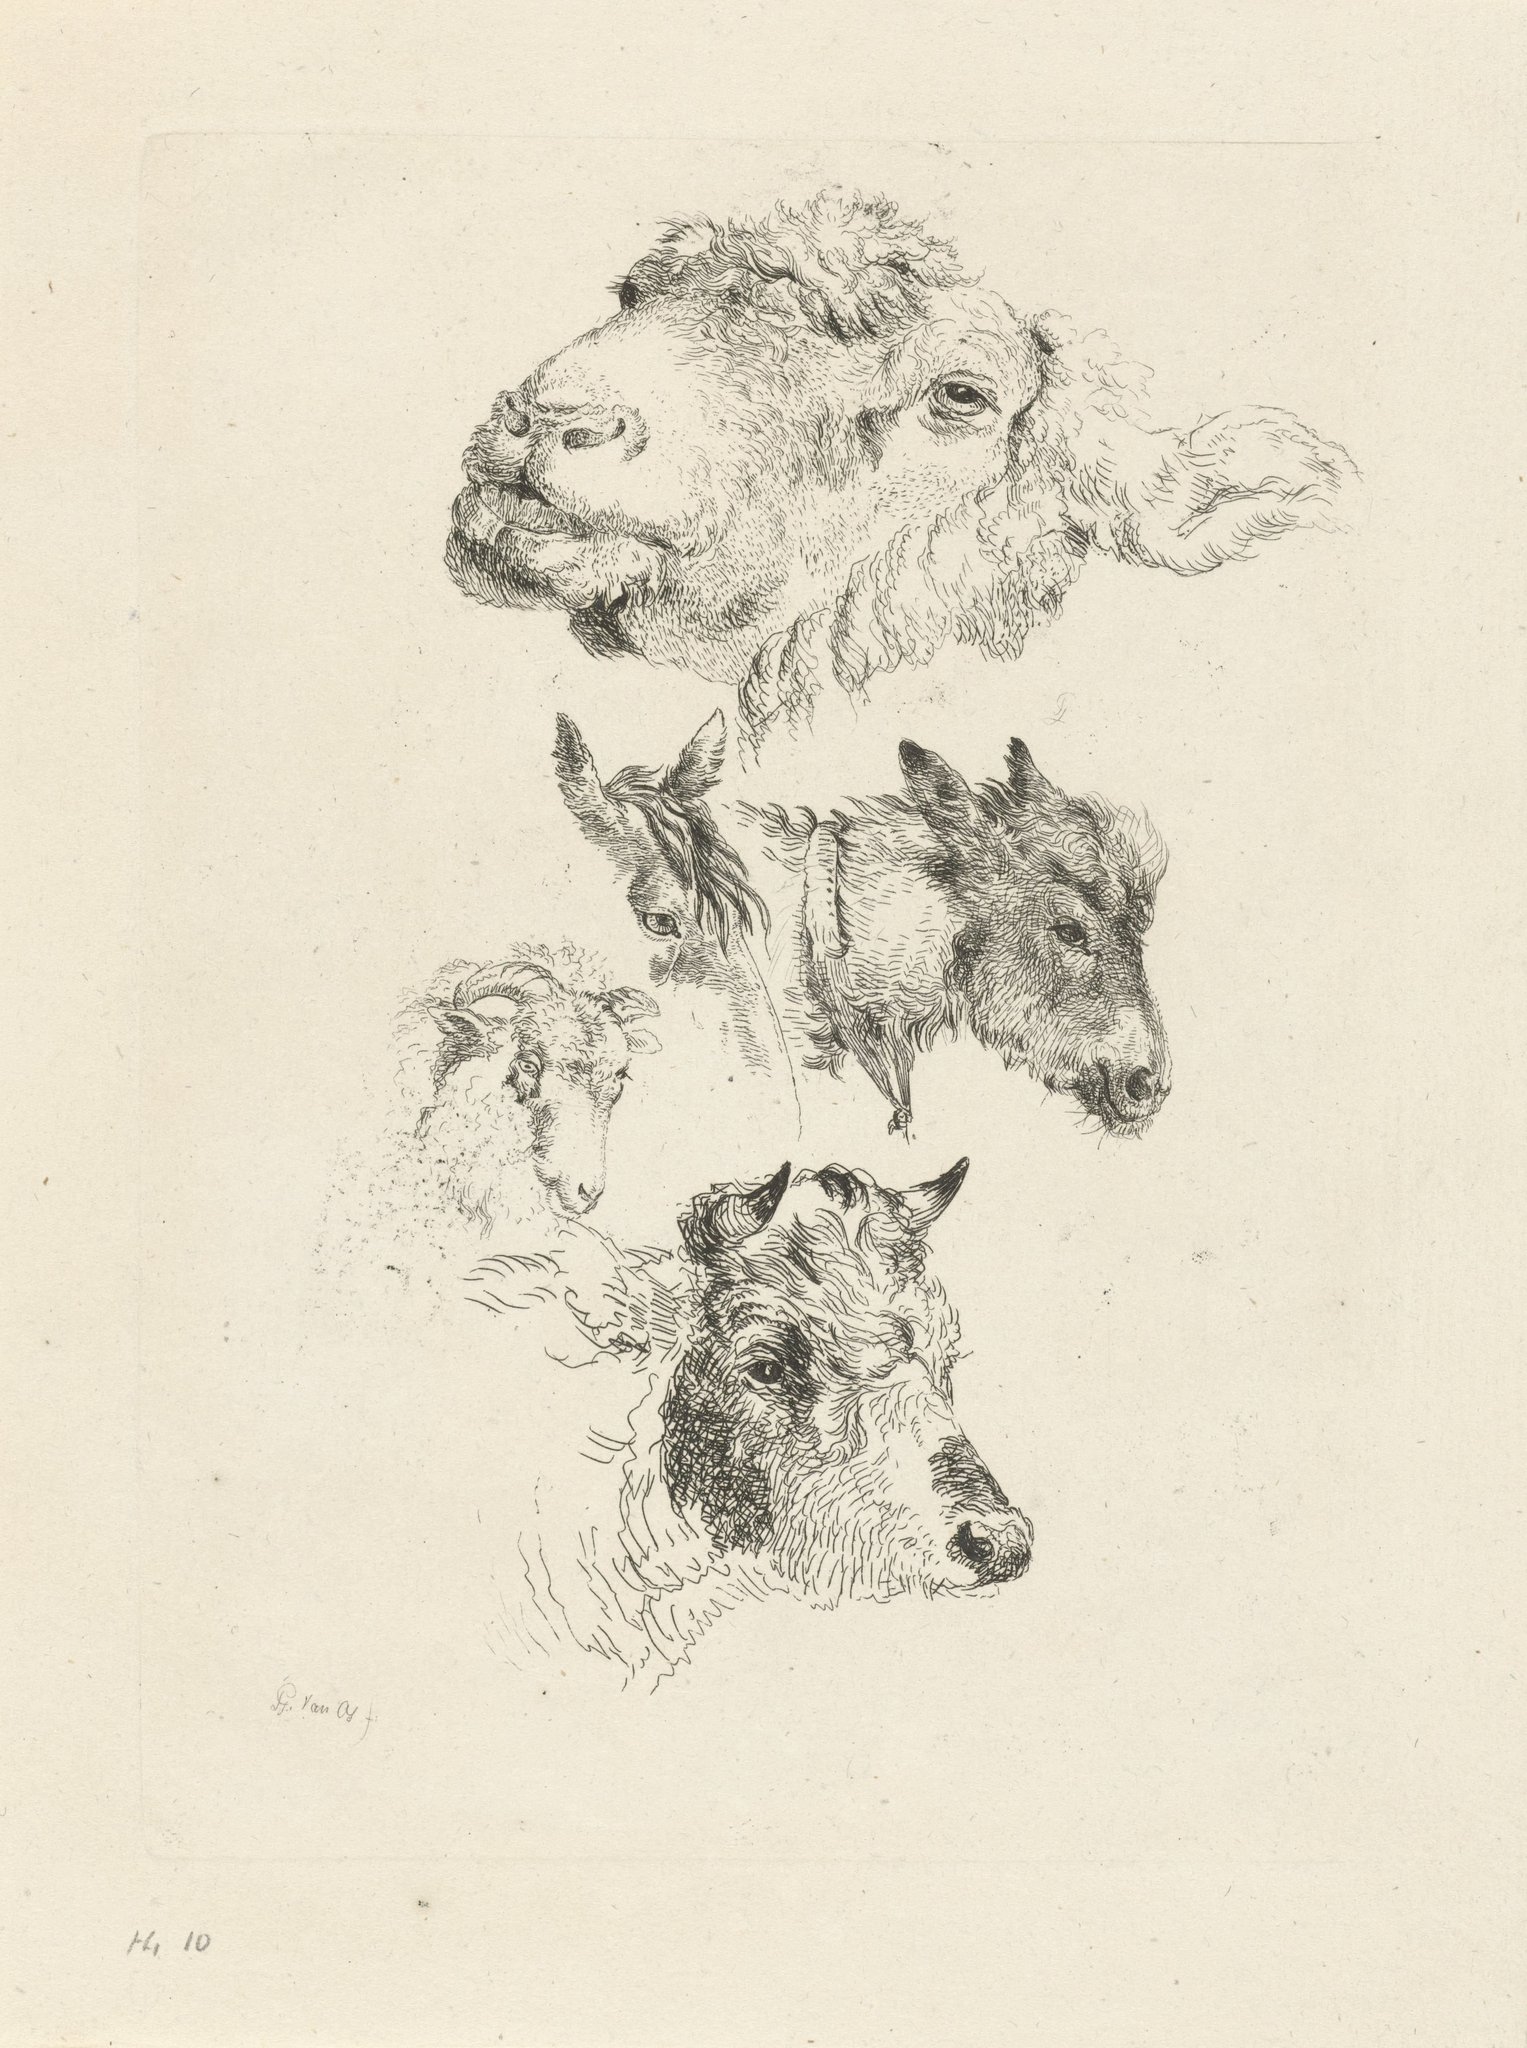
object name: print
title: Studieblad met schaap-, paard- , ezel- , ram- en stierenkop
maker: pieter gerardus van os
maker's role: draughtsman, painter, print maker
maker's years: 1776-1839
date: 1791-1839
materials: paper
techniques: etching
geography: netherlands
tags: domestic animal kept outside the house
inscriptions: collector's mark: Lugt 2228